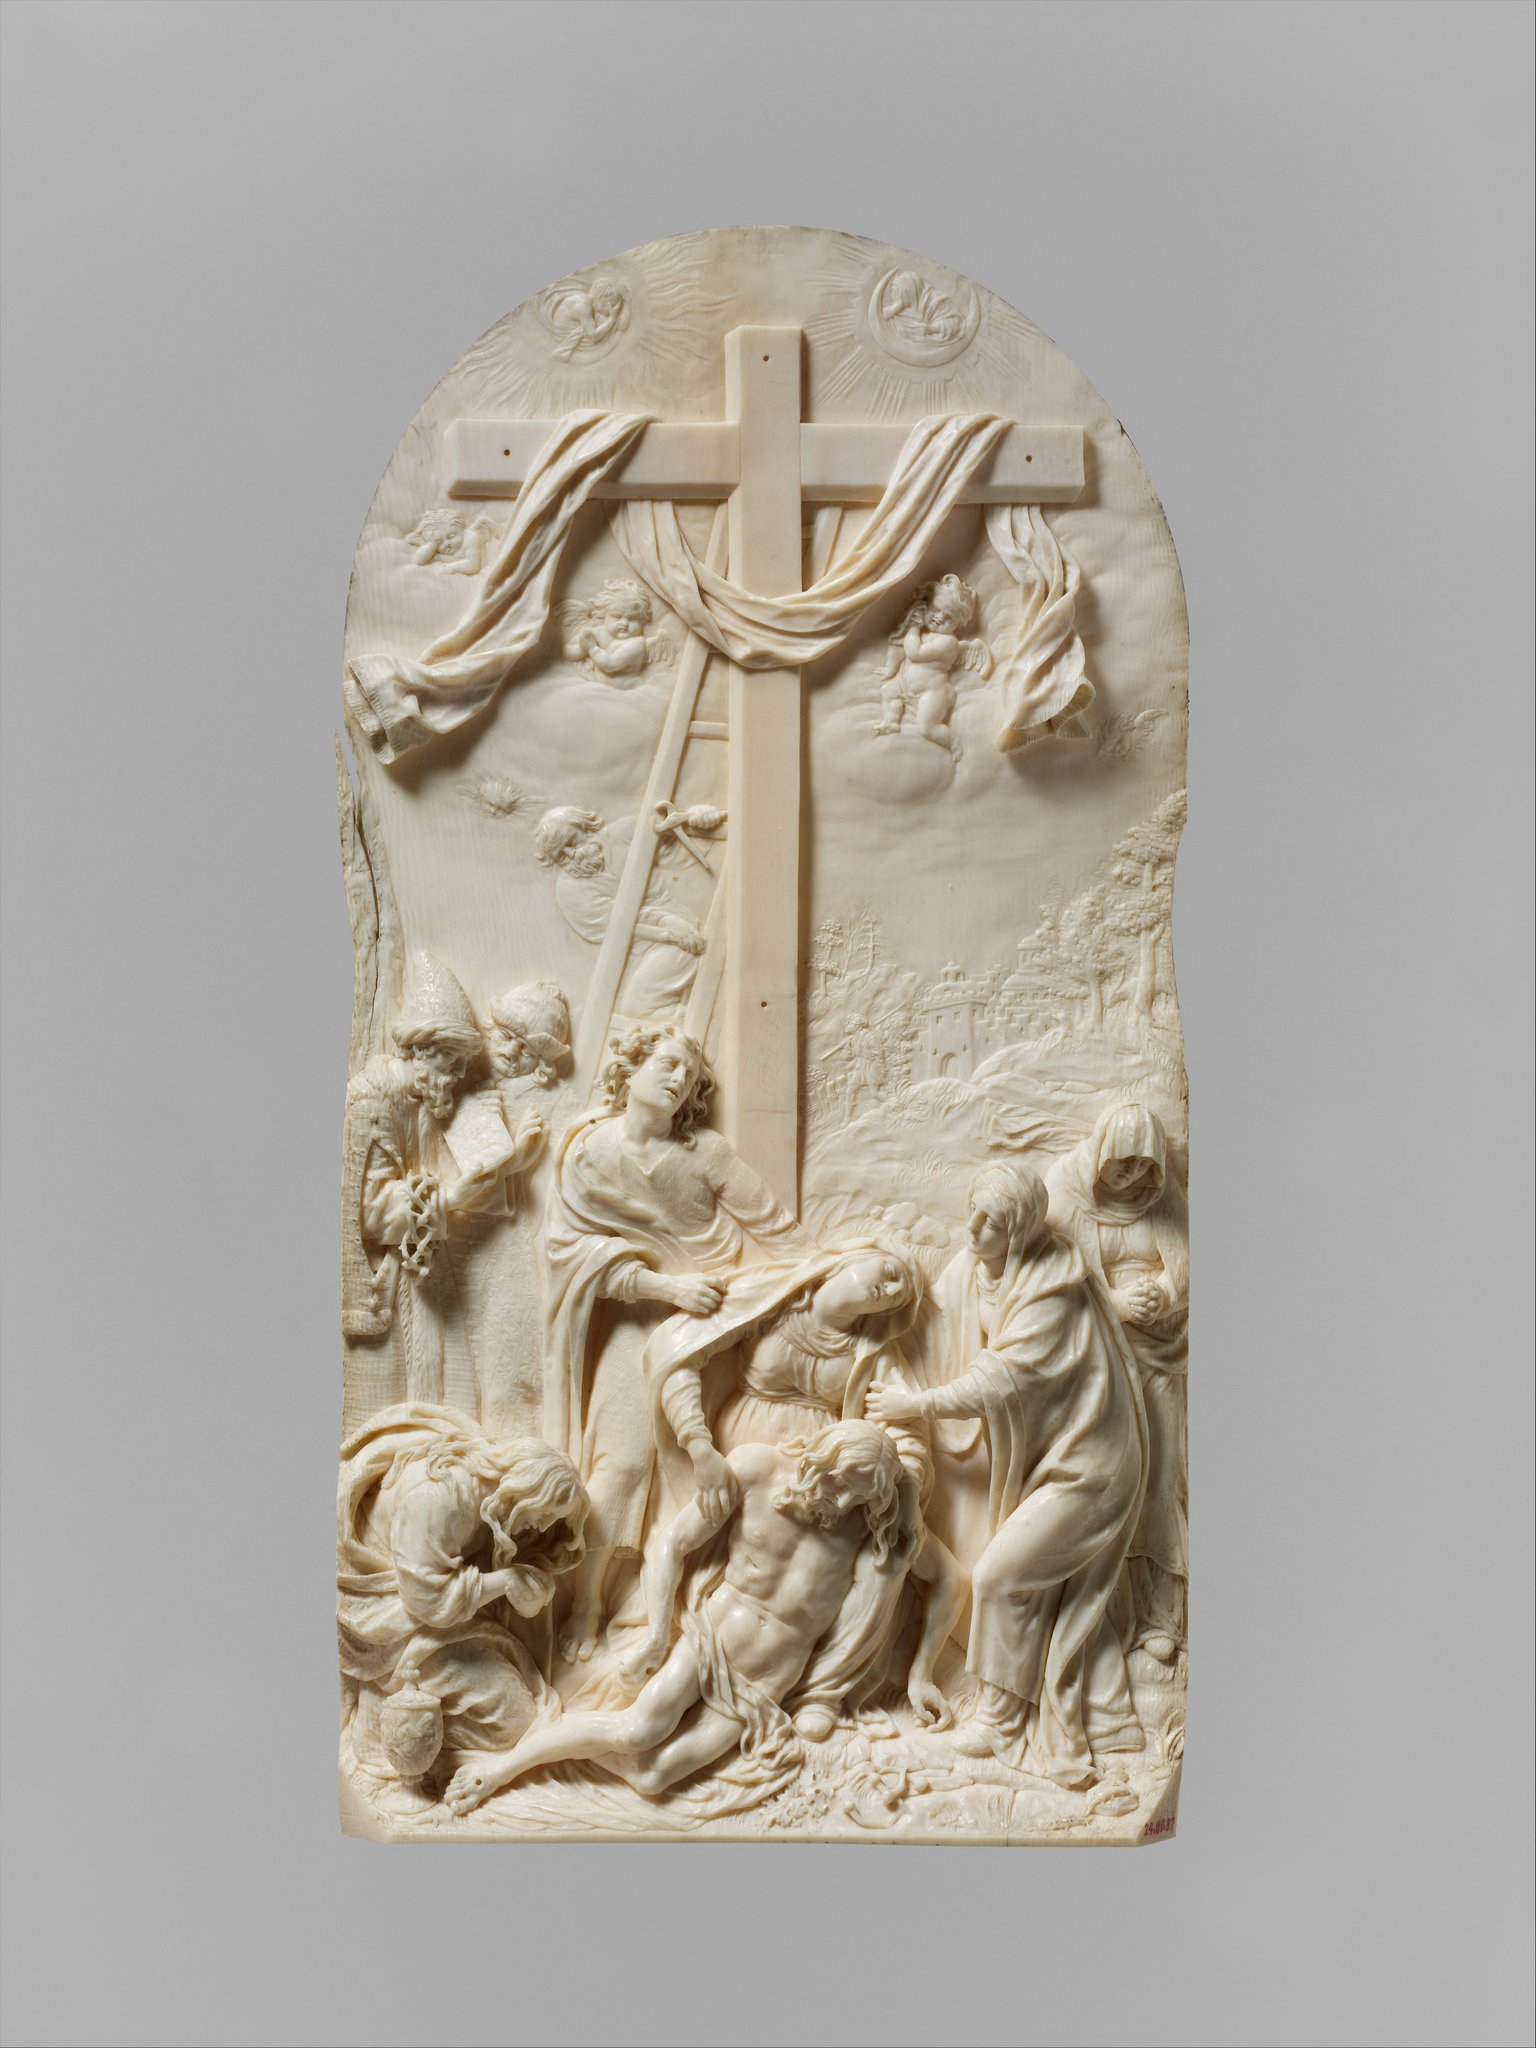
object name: plaque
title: Lamentation Beneath the Cross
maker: adam lenckhart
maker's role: artist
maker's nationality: german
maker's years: 1610-1661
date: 1632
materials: ivory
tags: sadness,christ,mary magdalene,virgin mary,cross,lamentation